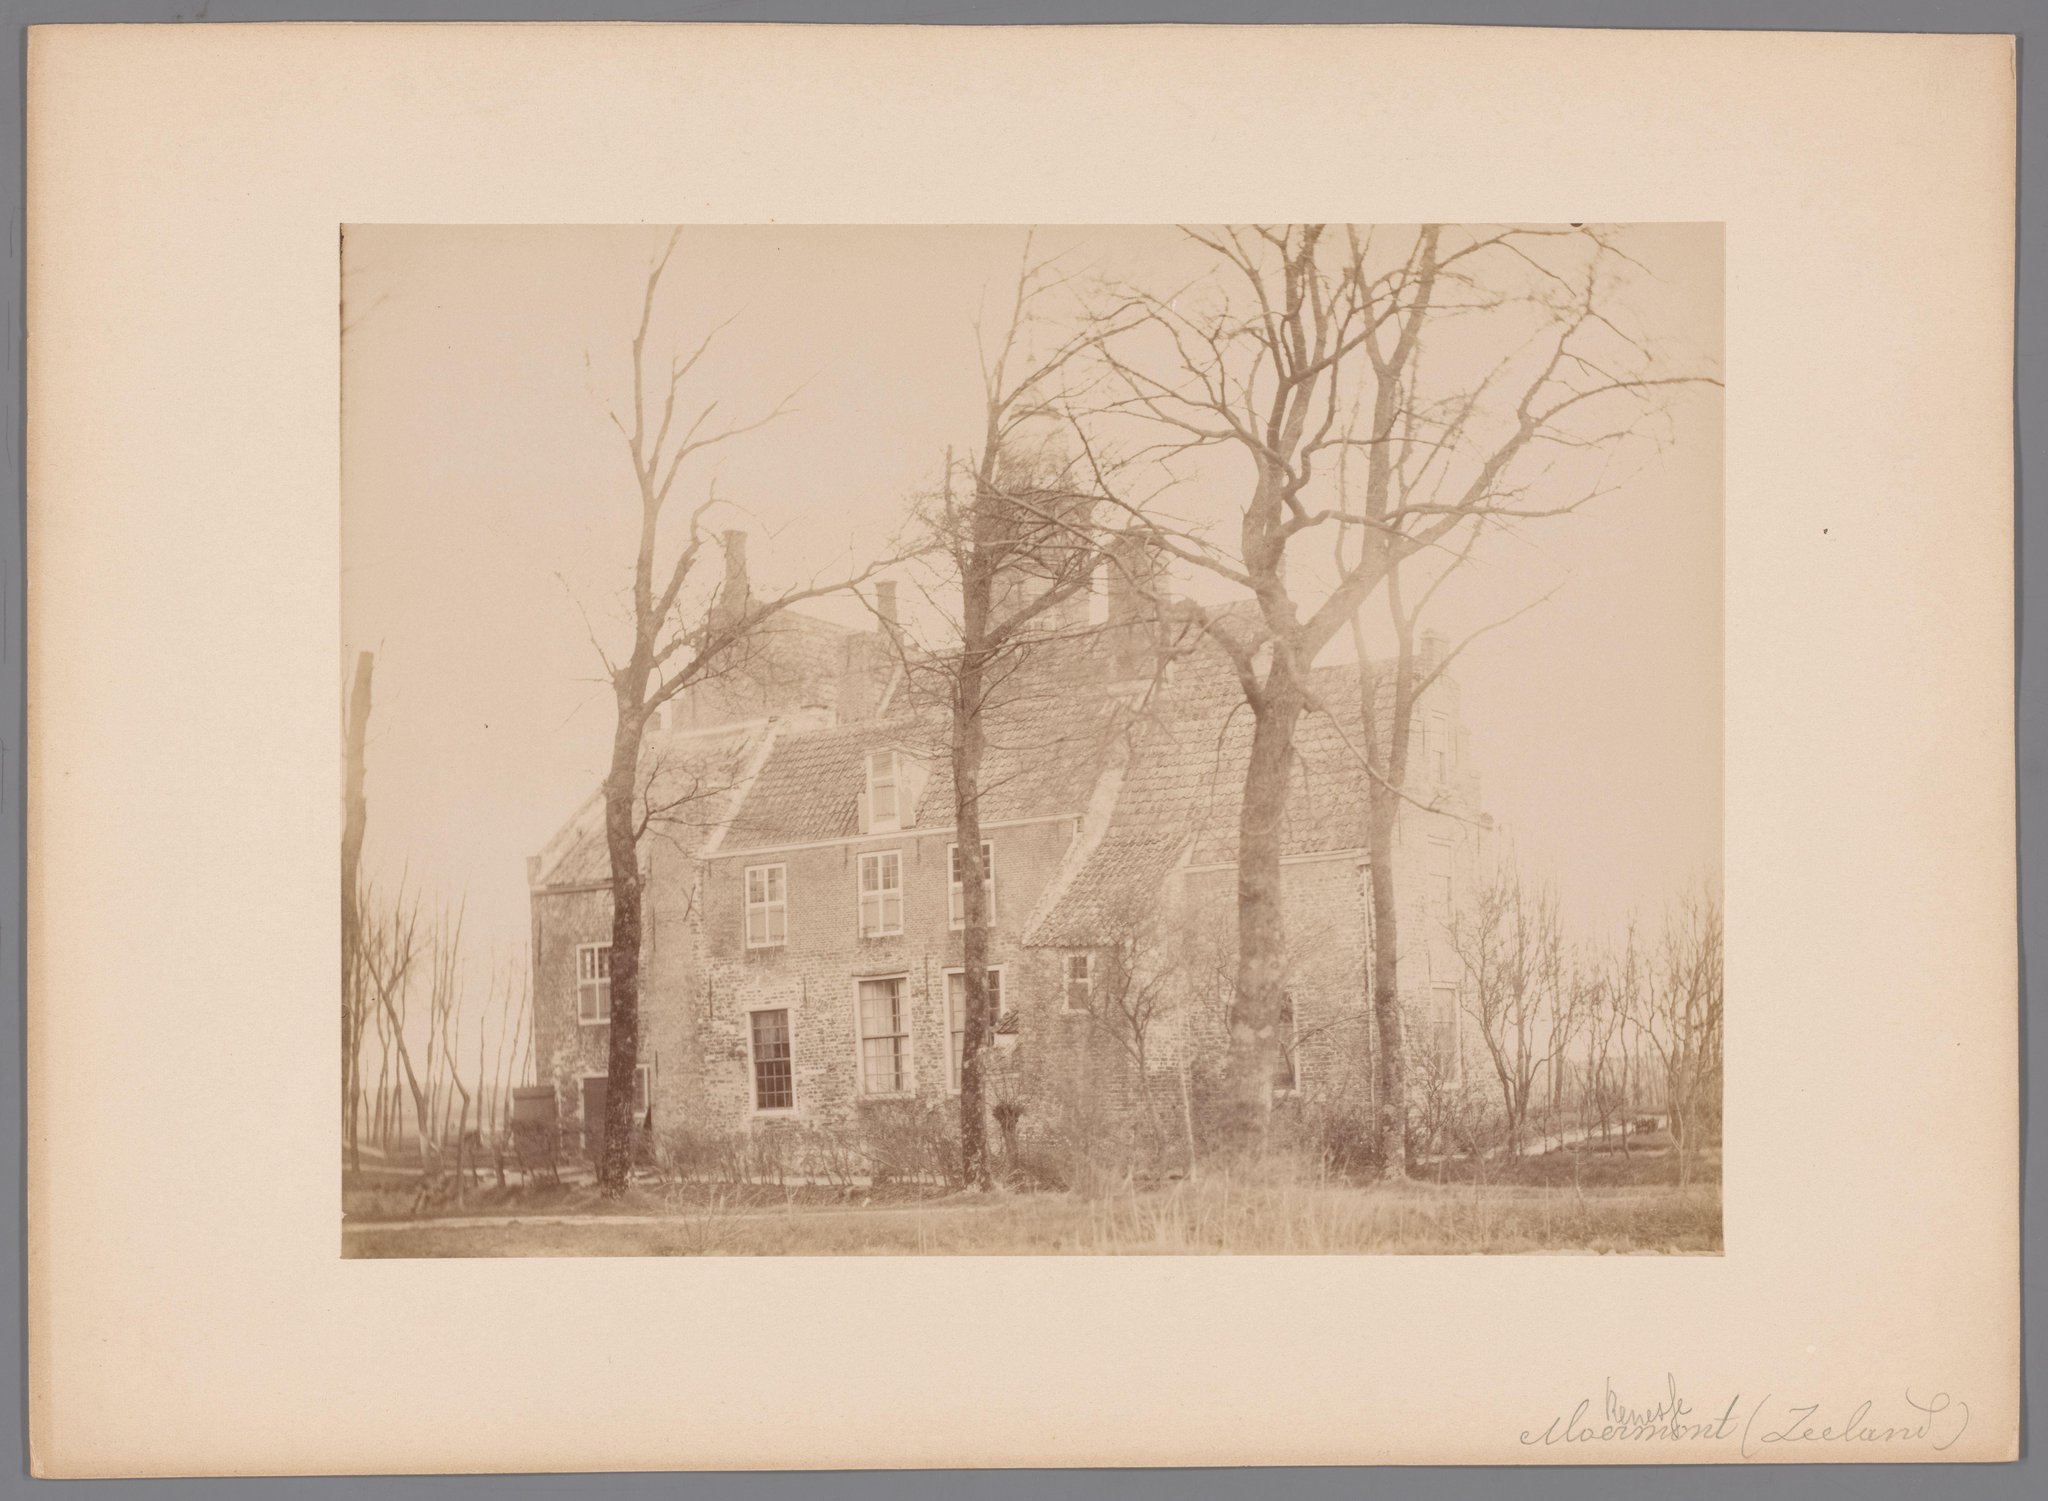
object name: photograph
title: Gezicht op Slot Moermond te Renesse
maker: anoniem (monumentenzorg)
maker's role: fotograaf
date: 1890-1920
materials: cardboard, photographic support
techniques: albumen print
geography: renesse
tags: castle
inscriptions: annotation: ‘Kaseel Moermont/ Zeeland’, annotation: ‘Renesse Moermont (Zeeland)’